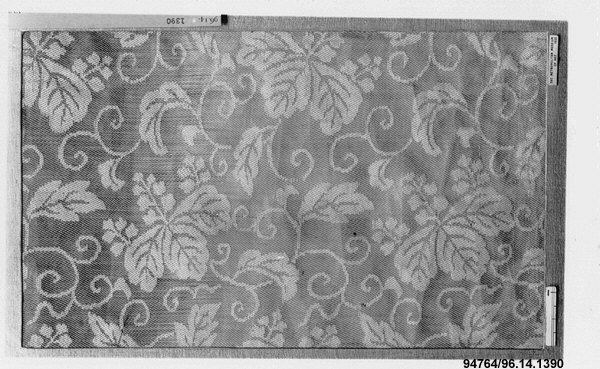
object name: textile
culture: japanese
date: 1701-1900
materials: silk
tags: leaves